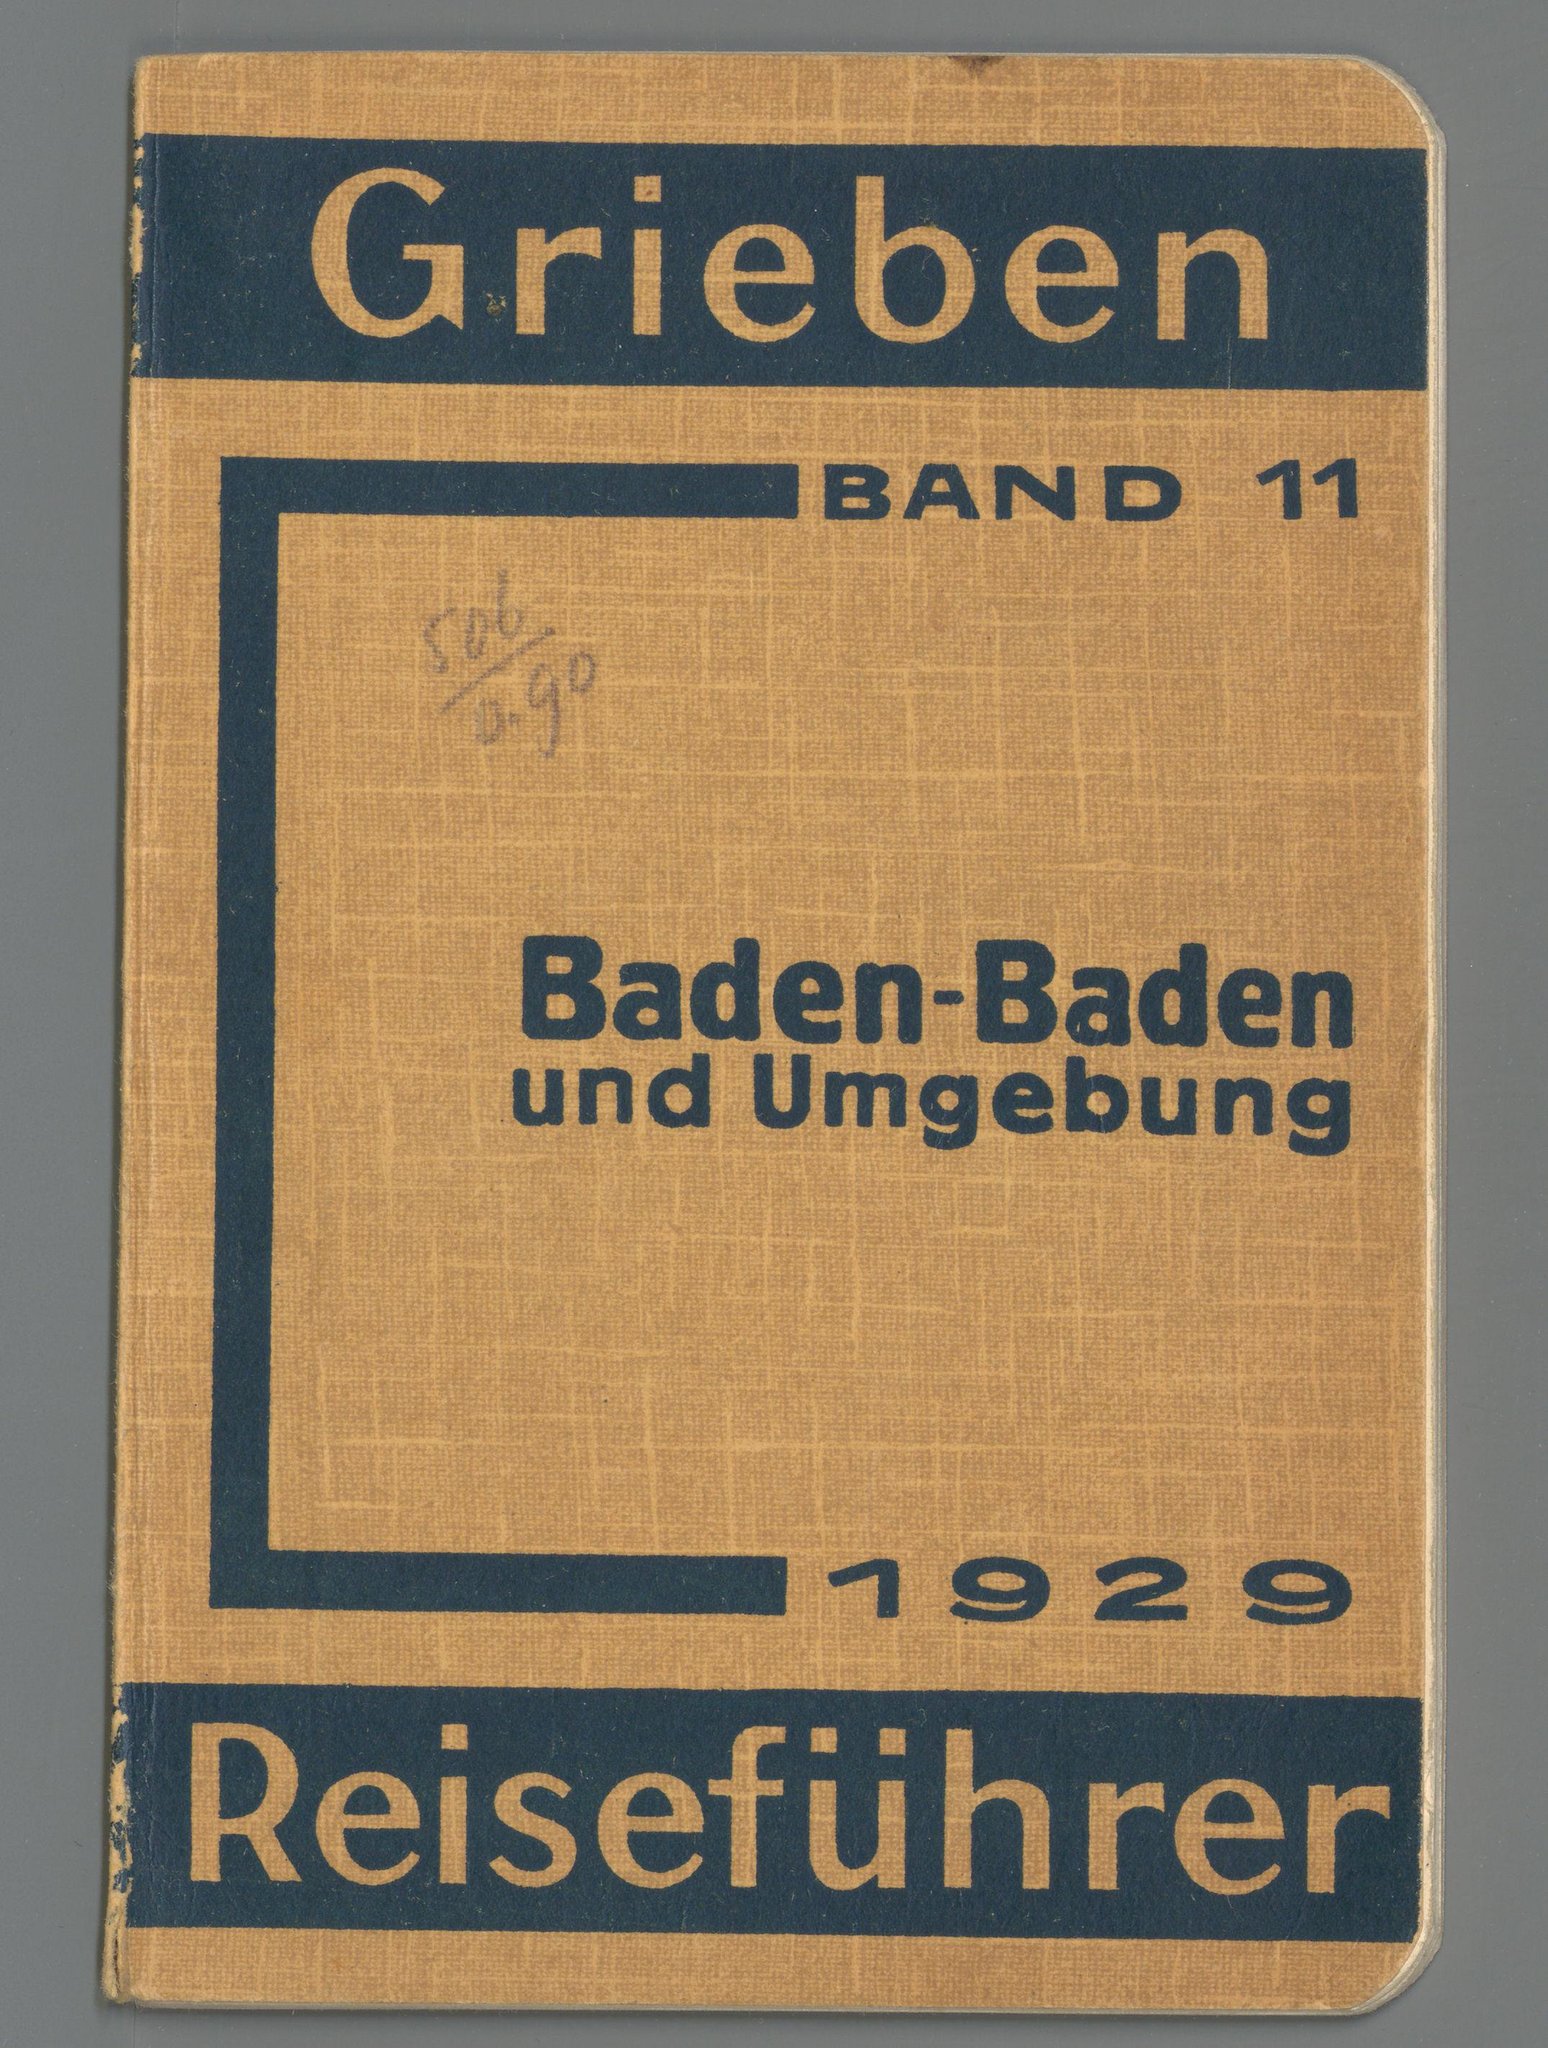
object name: book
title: Reisgids voor Baden-Baden en omgeving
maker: Anonymous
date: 1929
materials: cardboard, paper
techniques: letterpress printing, lithograph, printing block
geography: berlin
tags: maps of separate countries or regions, camera ~ photography, guide-book (~tourism)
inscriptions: inscription: ‘506/ 0.90’